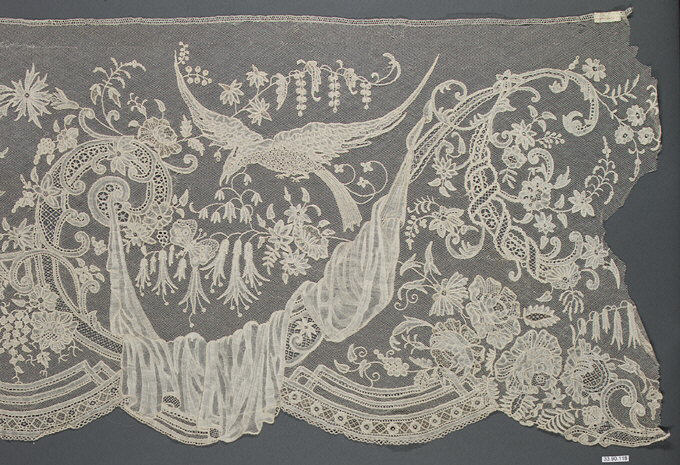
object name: flounce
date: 1851-1875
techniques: lace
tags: birds,flowers